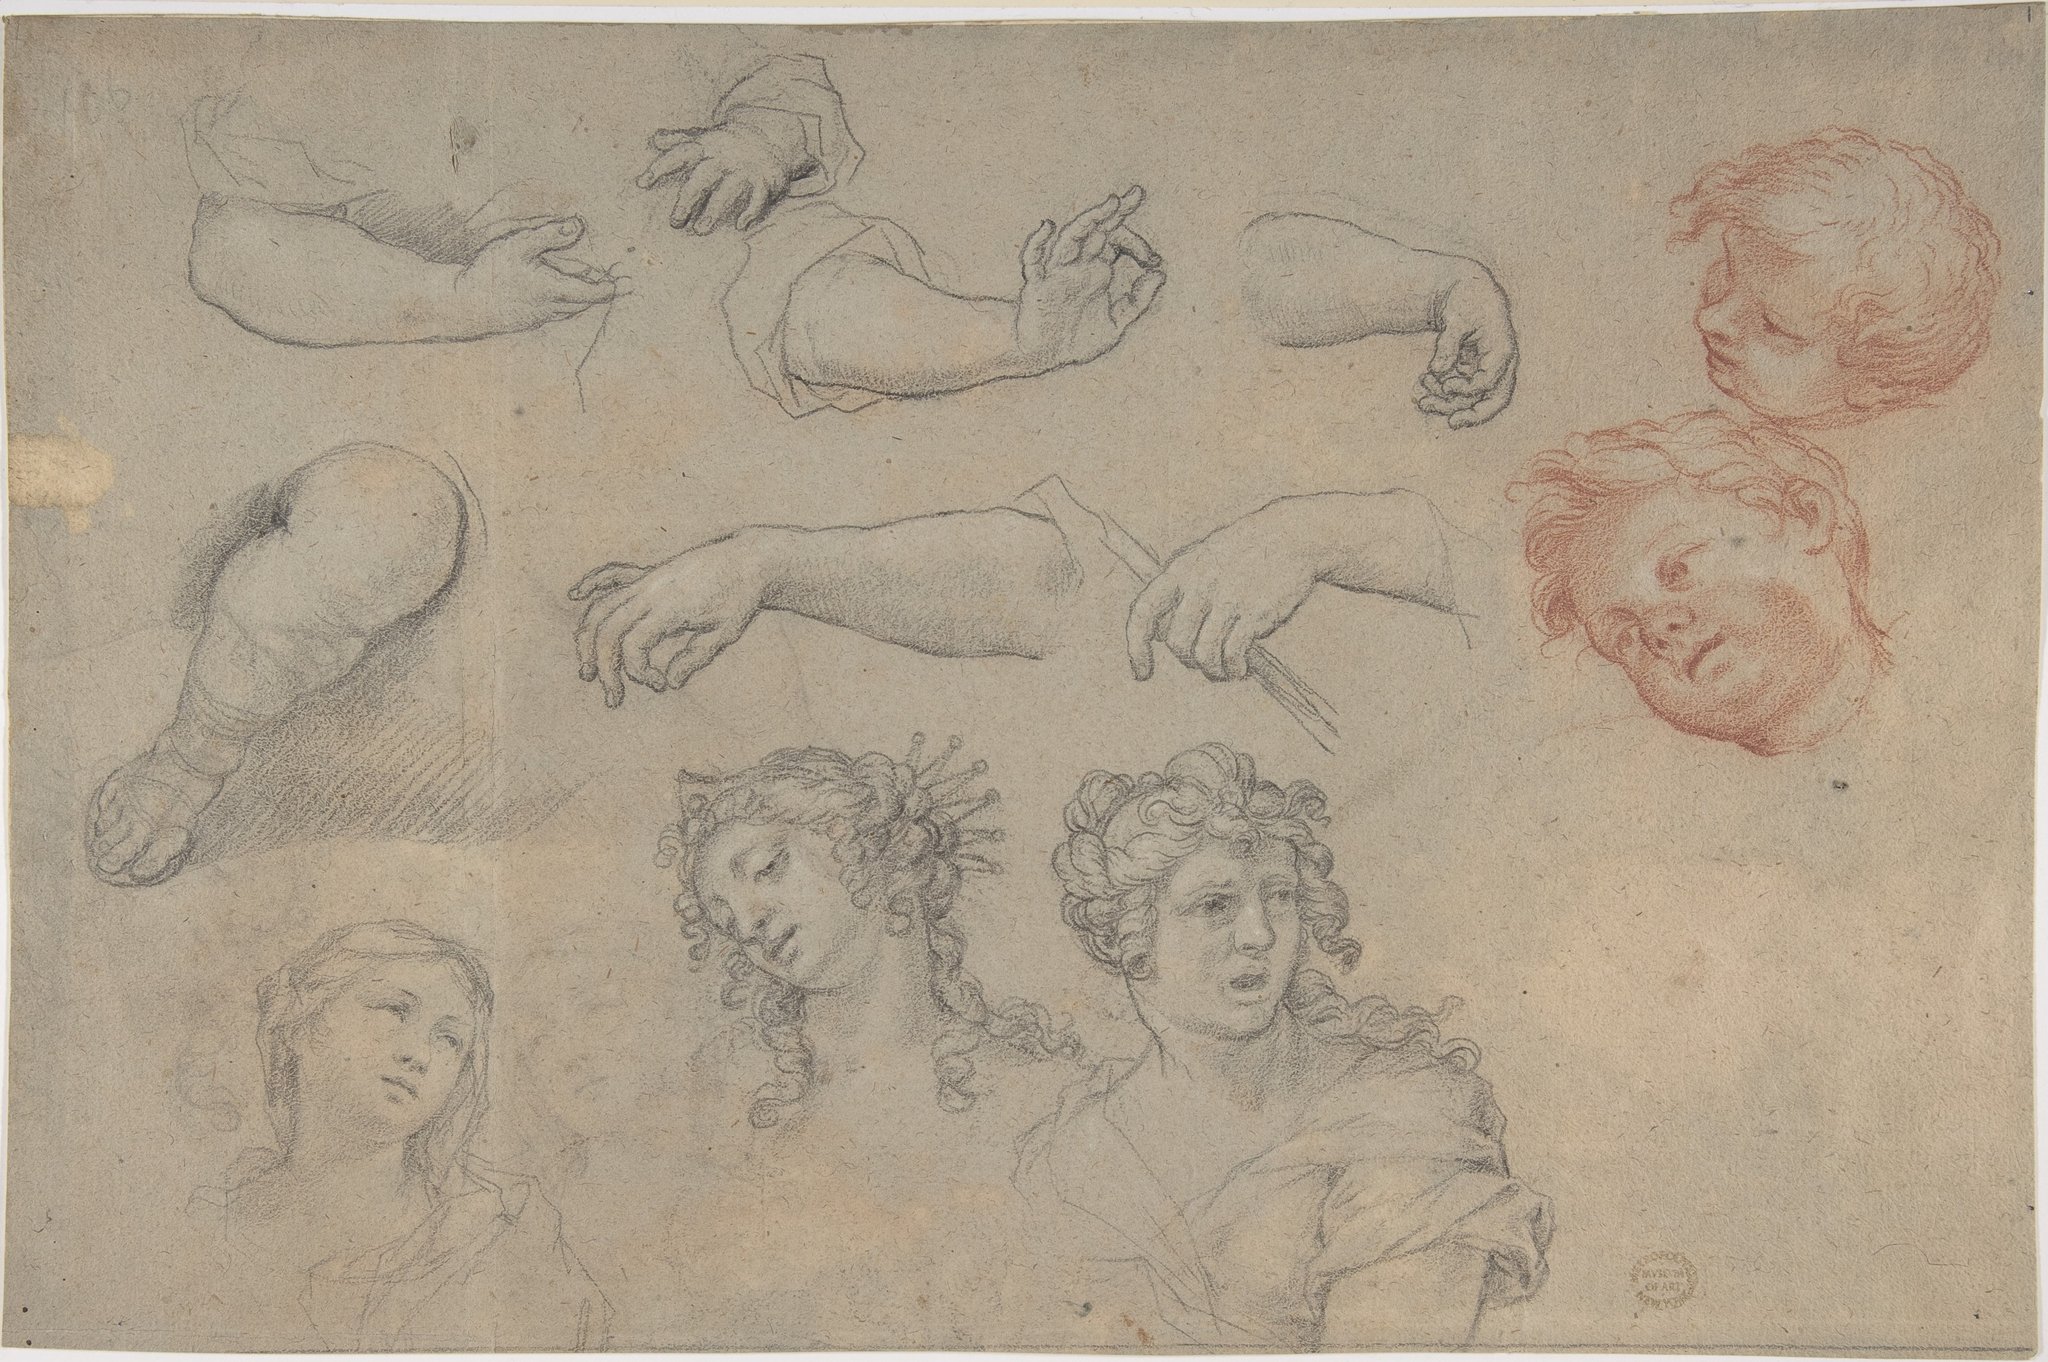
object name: drawing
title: Studies of Heads and Hands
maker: anonymous, french, 17th century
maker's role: artist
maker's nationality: french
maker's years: 1600-1700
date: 1601-1700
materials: chalk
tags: hands,heads